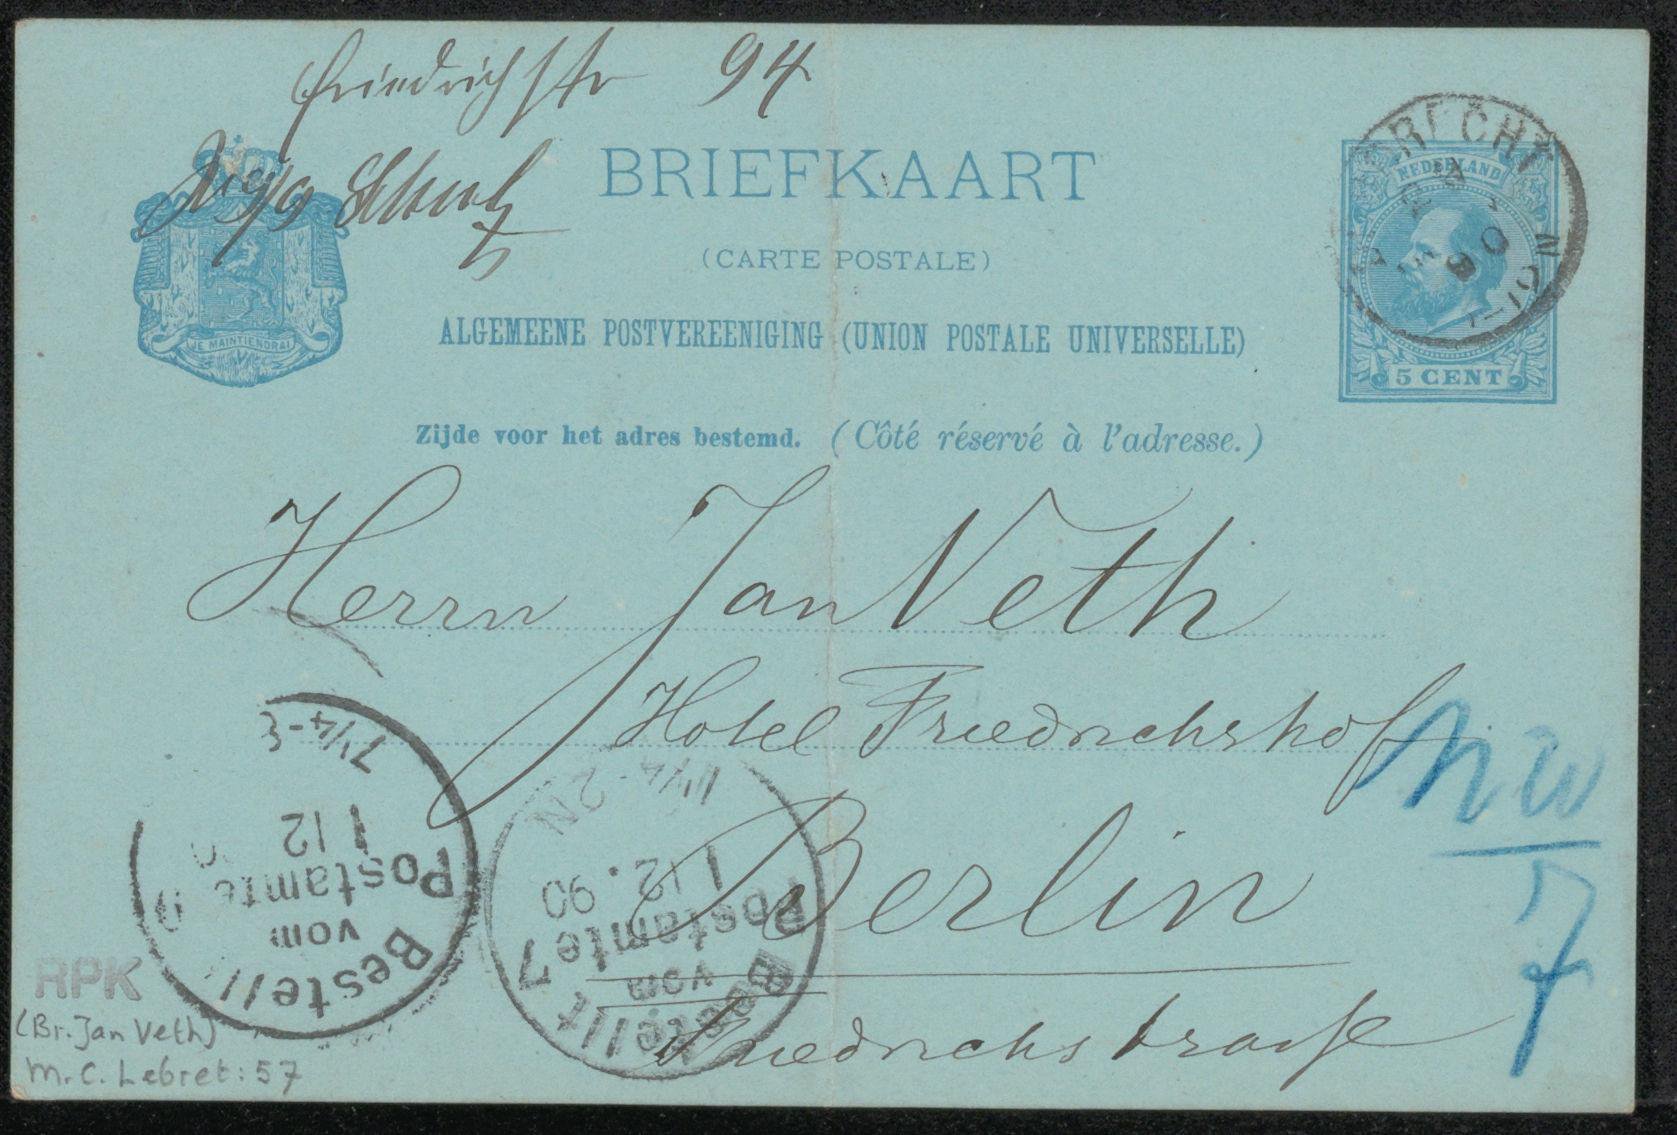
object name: postcard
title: Briefkaart aan Jan Veth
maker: martinus cornelis lebret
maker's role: verzamelaar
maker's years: 1833-1894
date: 1890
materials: cardboard, ink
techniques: pen, writing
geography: dordrecht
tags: painter, print maker, draughtsman, designer, jan veth, berlin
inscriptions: collector's mark: ‘RPK’